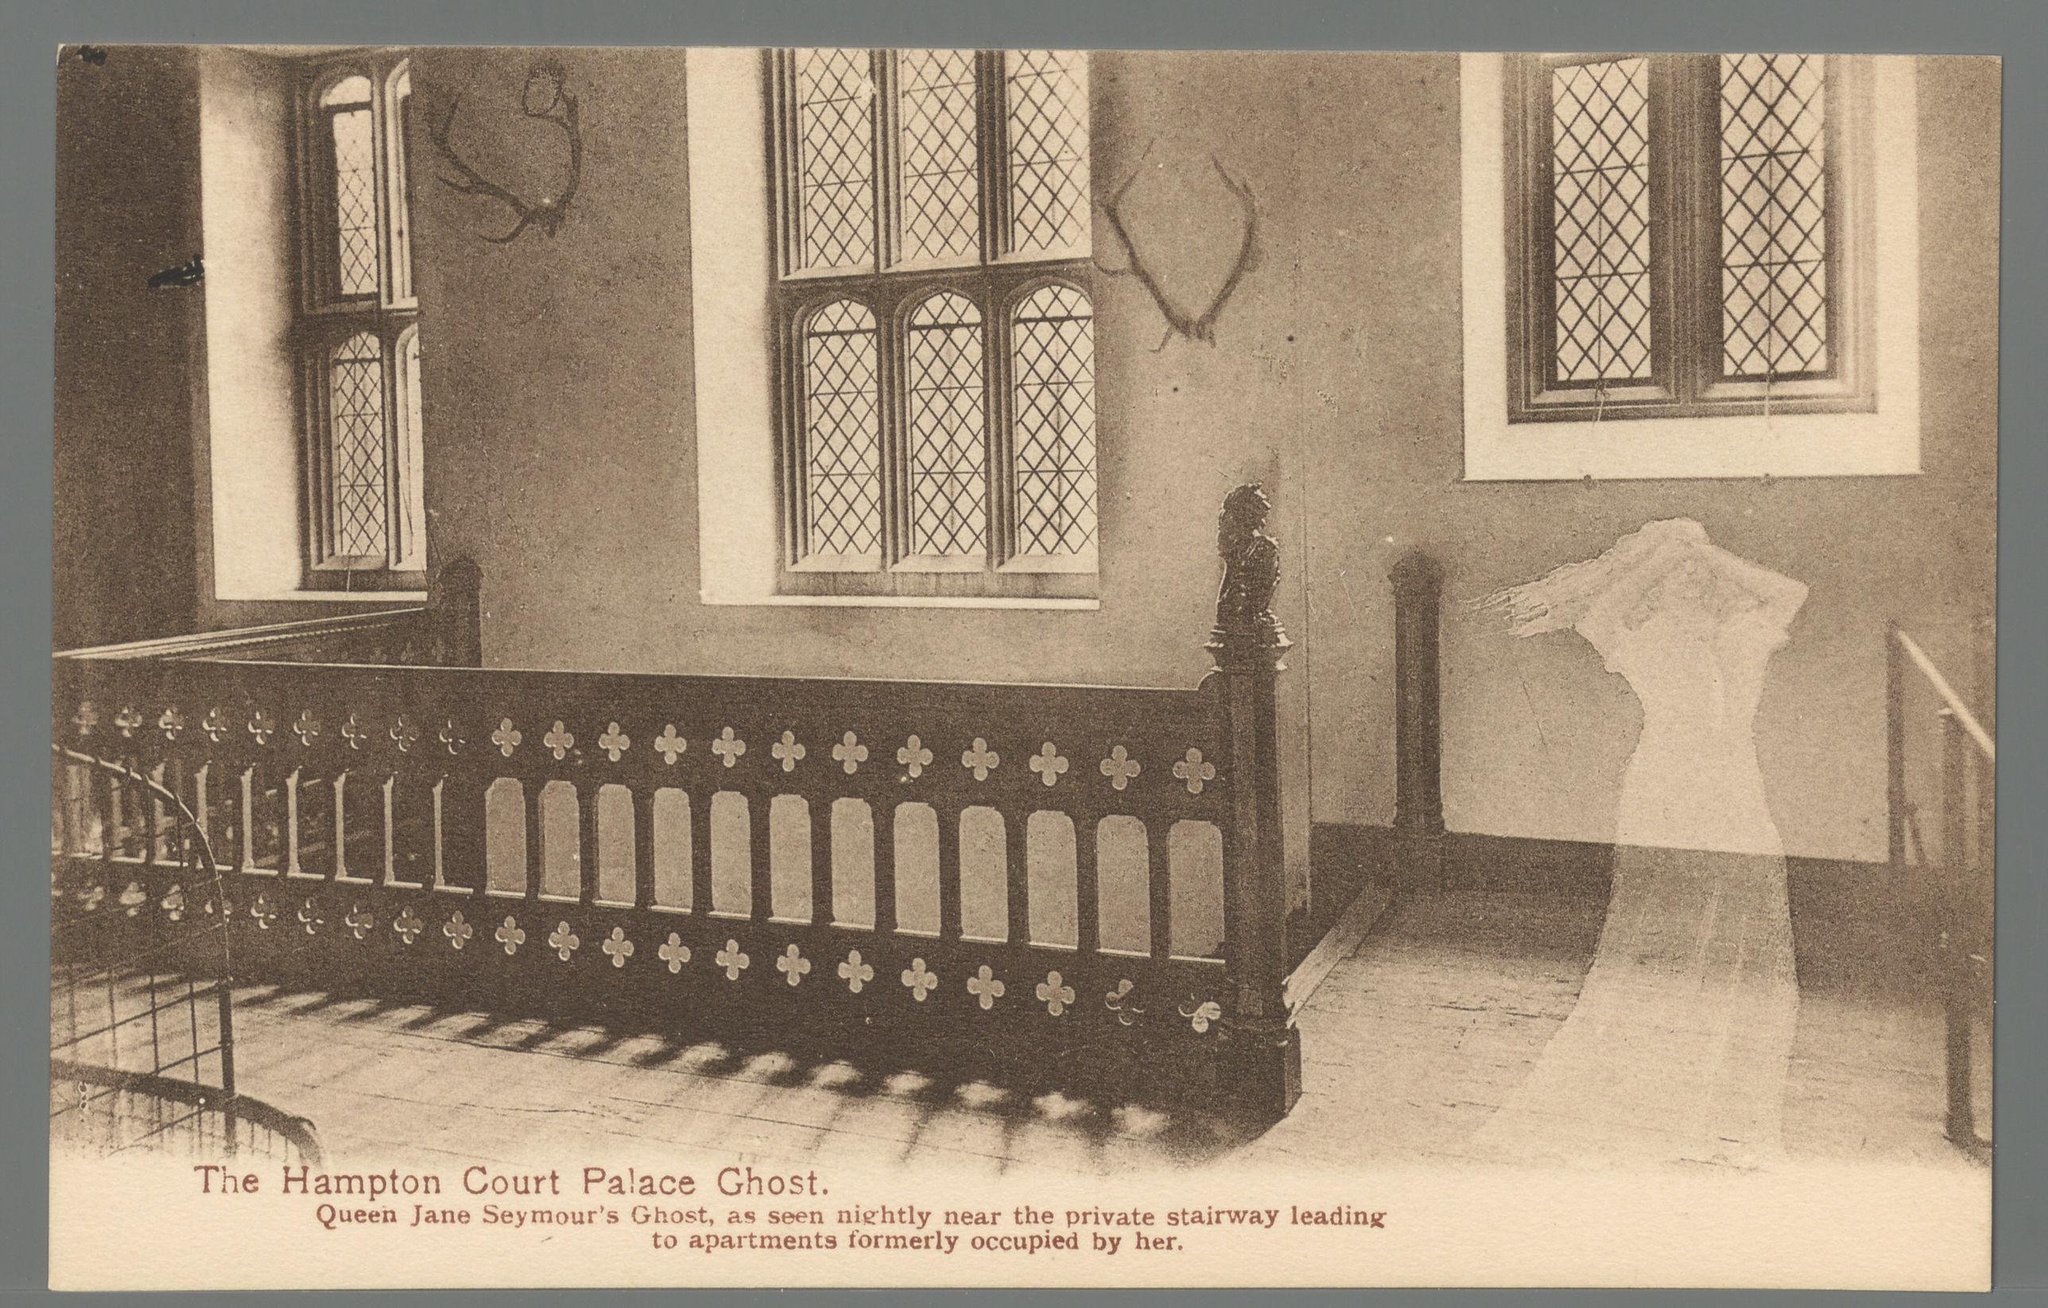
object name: ansichtkaart, prentbriefkaart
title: The Morland Series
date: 1902-1930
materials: cardboard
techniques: photograph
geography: england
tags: palace, staircase, spirit, ghost